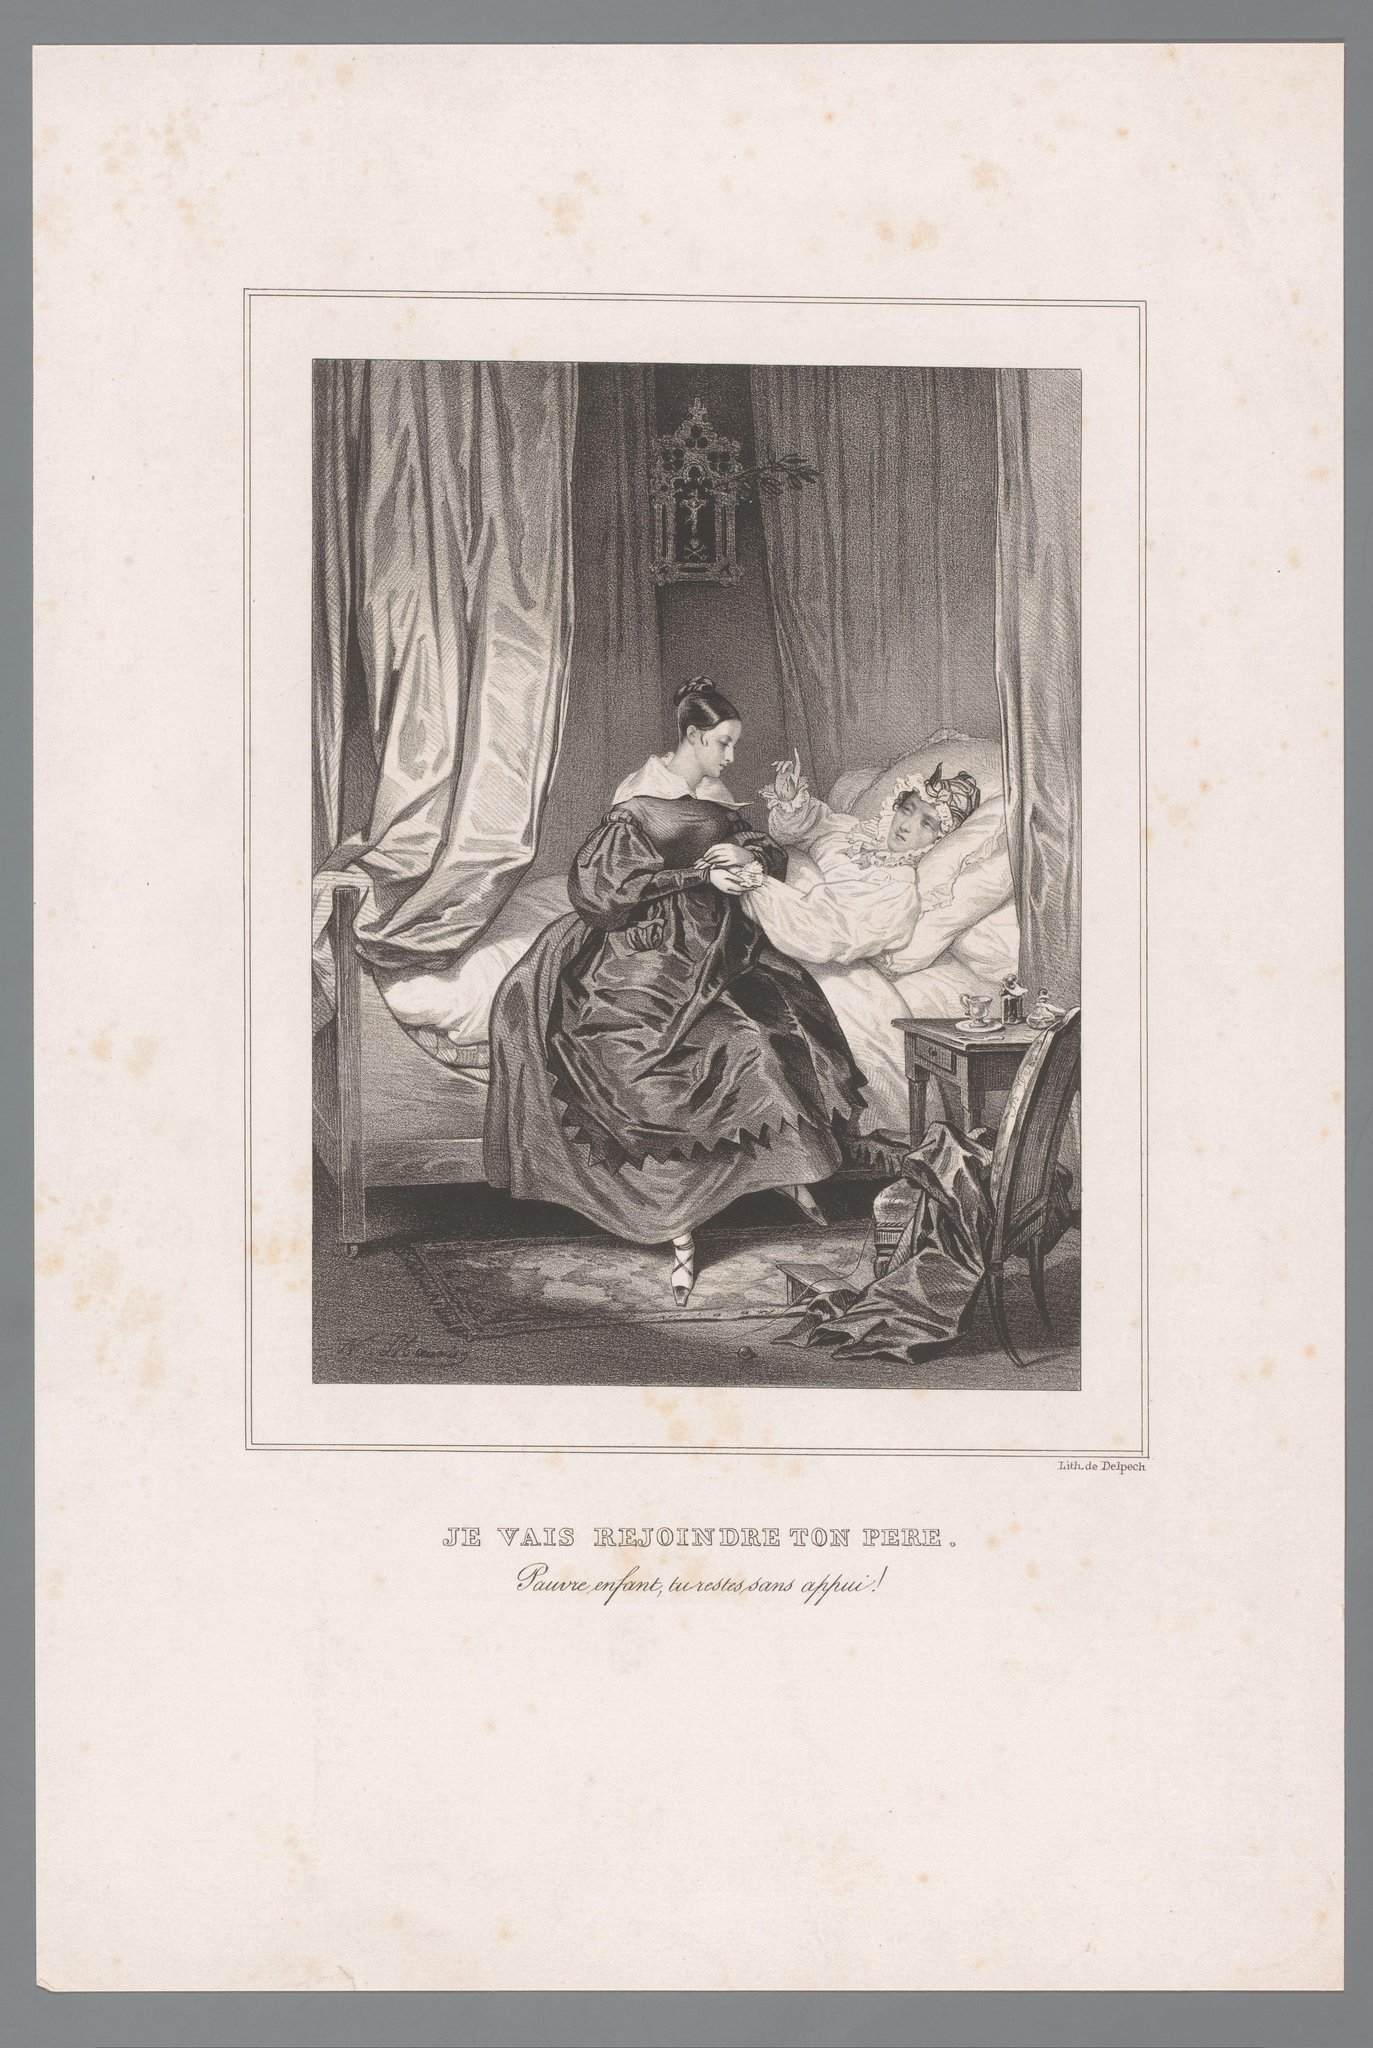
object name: print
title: Je vais rejoindre ton pere. Pauvre enfant, tu restes sans appui!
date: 1825-1842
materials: paper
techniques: lithograph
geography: paris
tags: natural death, intrigue, specific works of literature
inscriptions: collector's mark: Lugt 2760, collector's mark: Lugt 2228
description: Het verhaal is gebaseerd op het boek 'Les liaisons dangereuses' van Pierre Choderlos de Laclos.